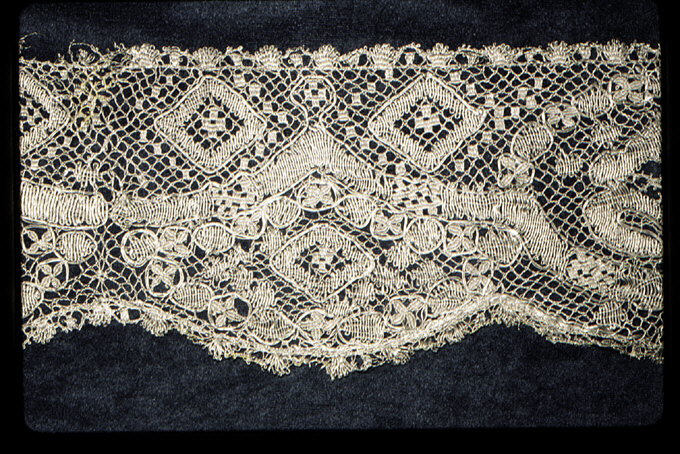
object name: rochet cuff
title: Cuff for a rochet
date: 1701-1800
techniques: lace